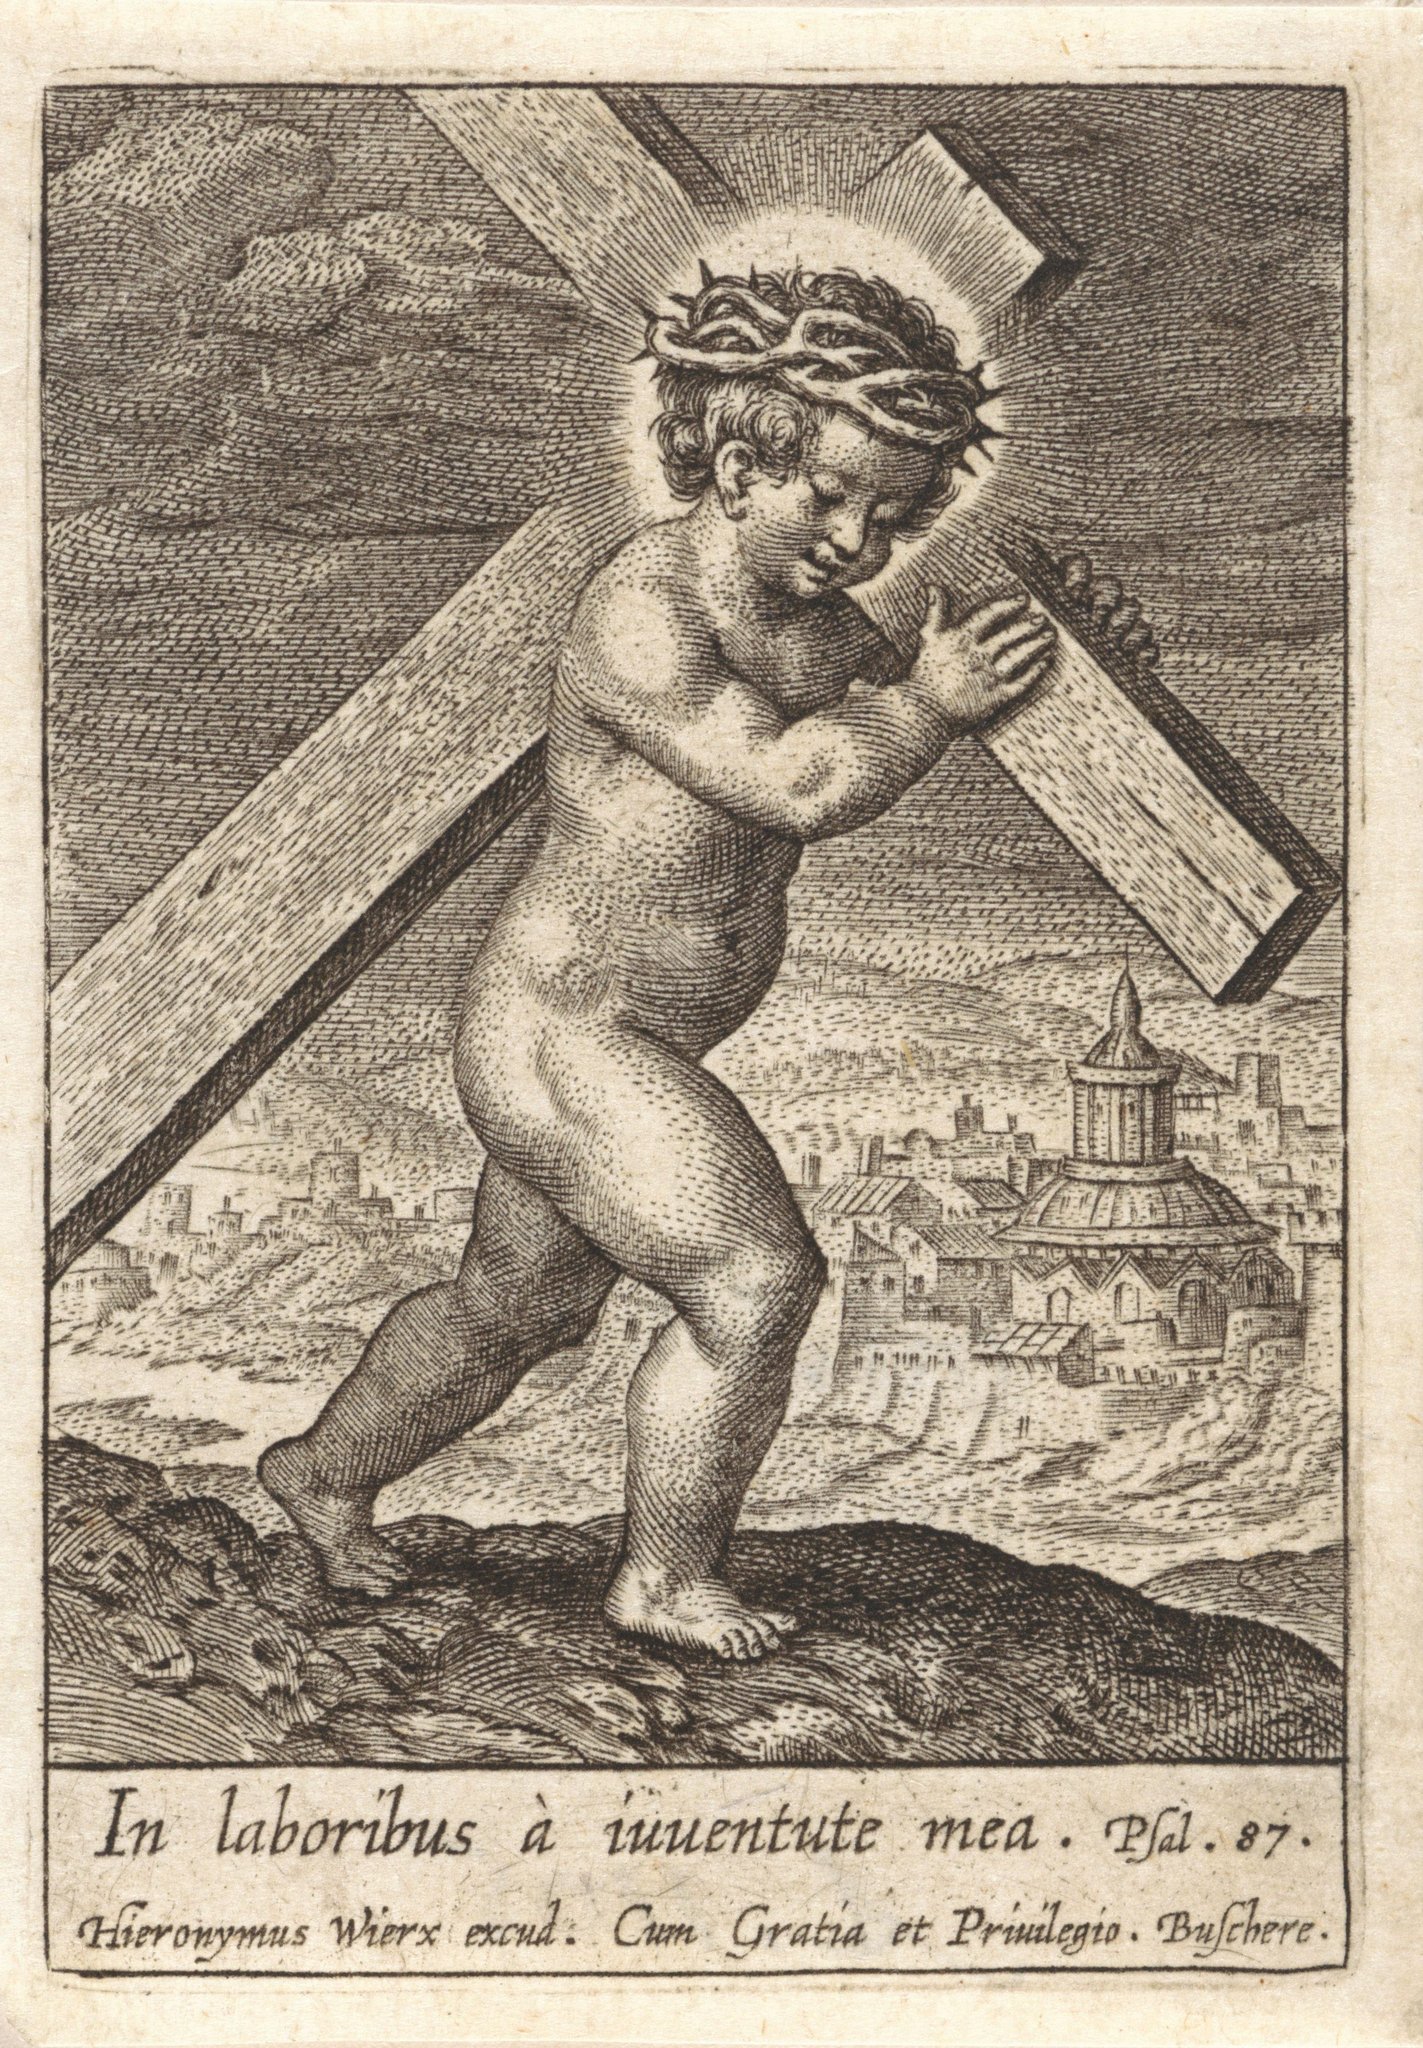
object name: print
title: Christuskind draagt het kruis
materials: paper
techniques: engraving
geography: antwerp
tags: christ-child carrying the cross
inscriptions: collector's mark: Lugt 2228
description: Het Christuskind draagt het Kruis. Het kind is gekroond met de doornenkroon. In de marge een Bijbelcitaat uit Ps. 87 in het Latijn.